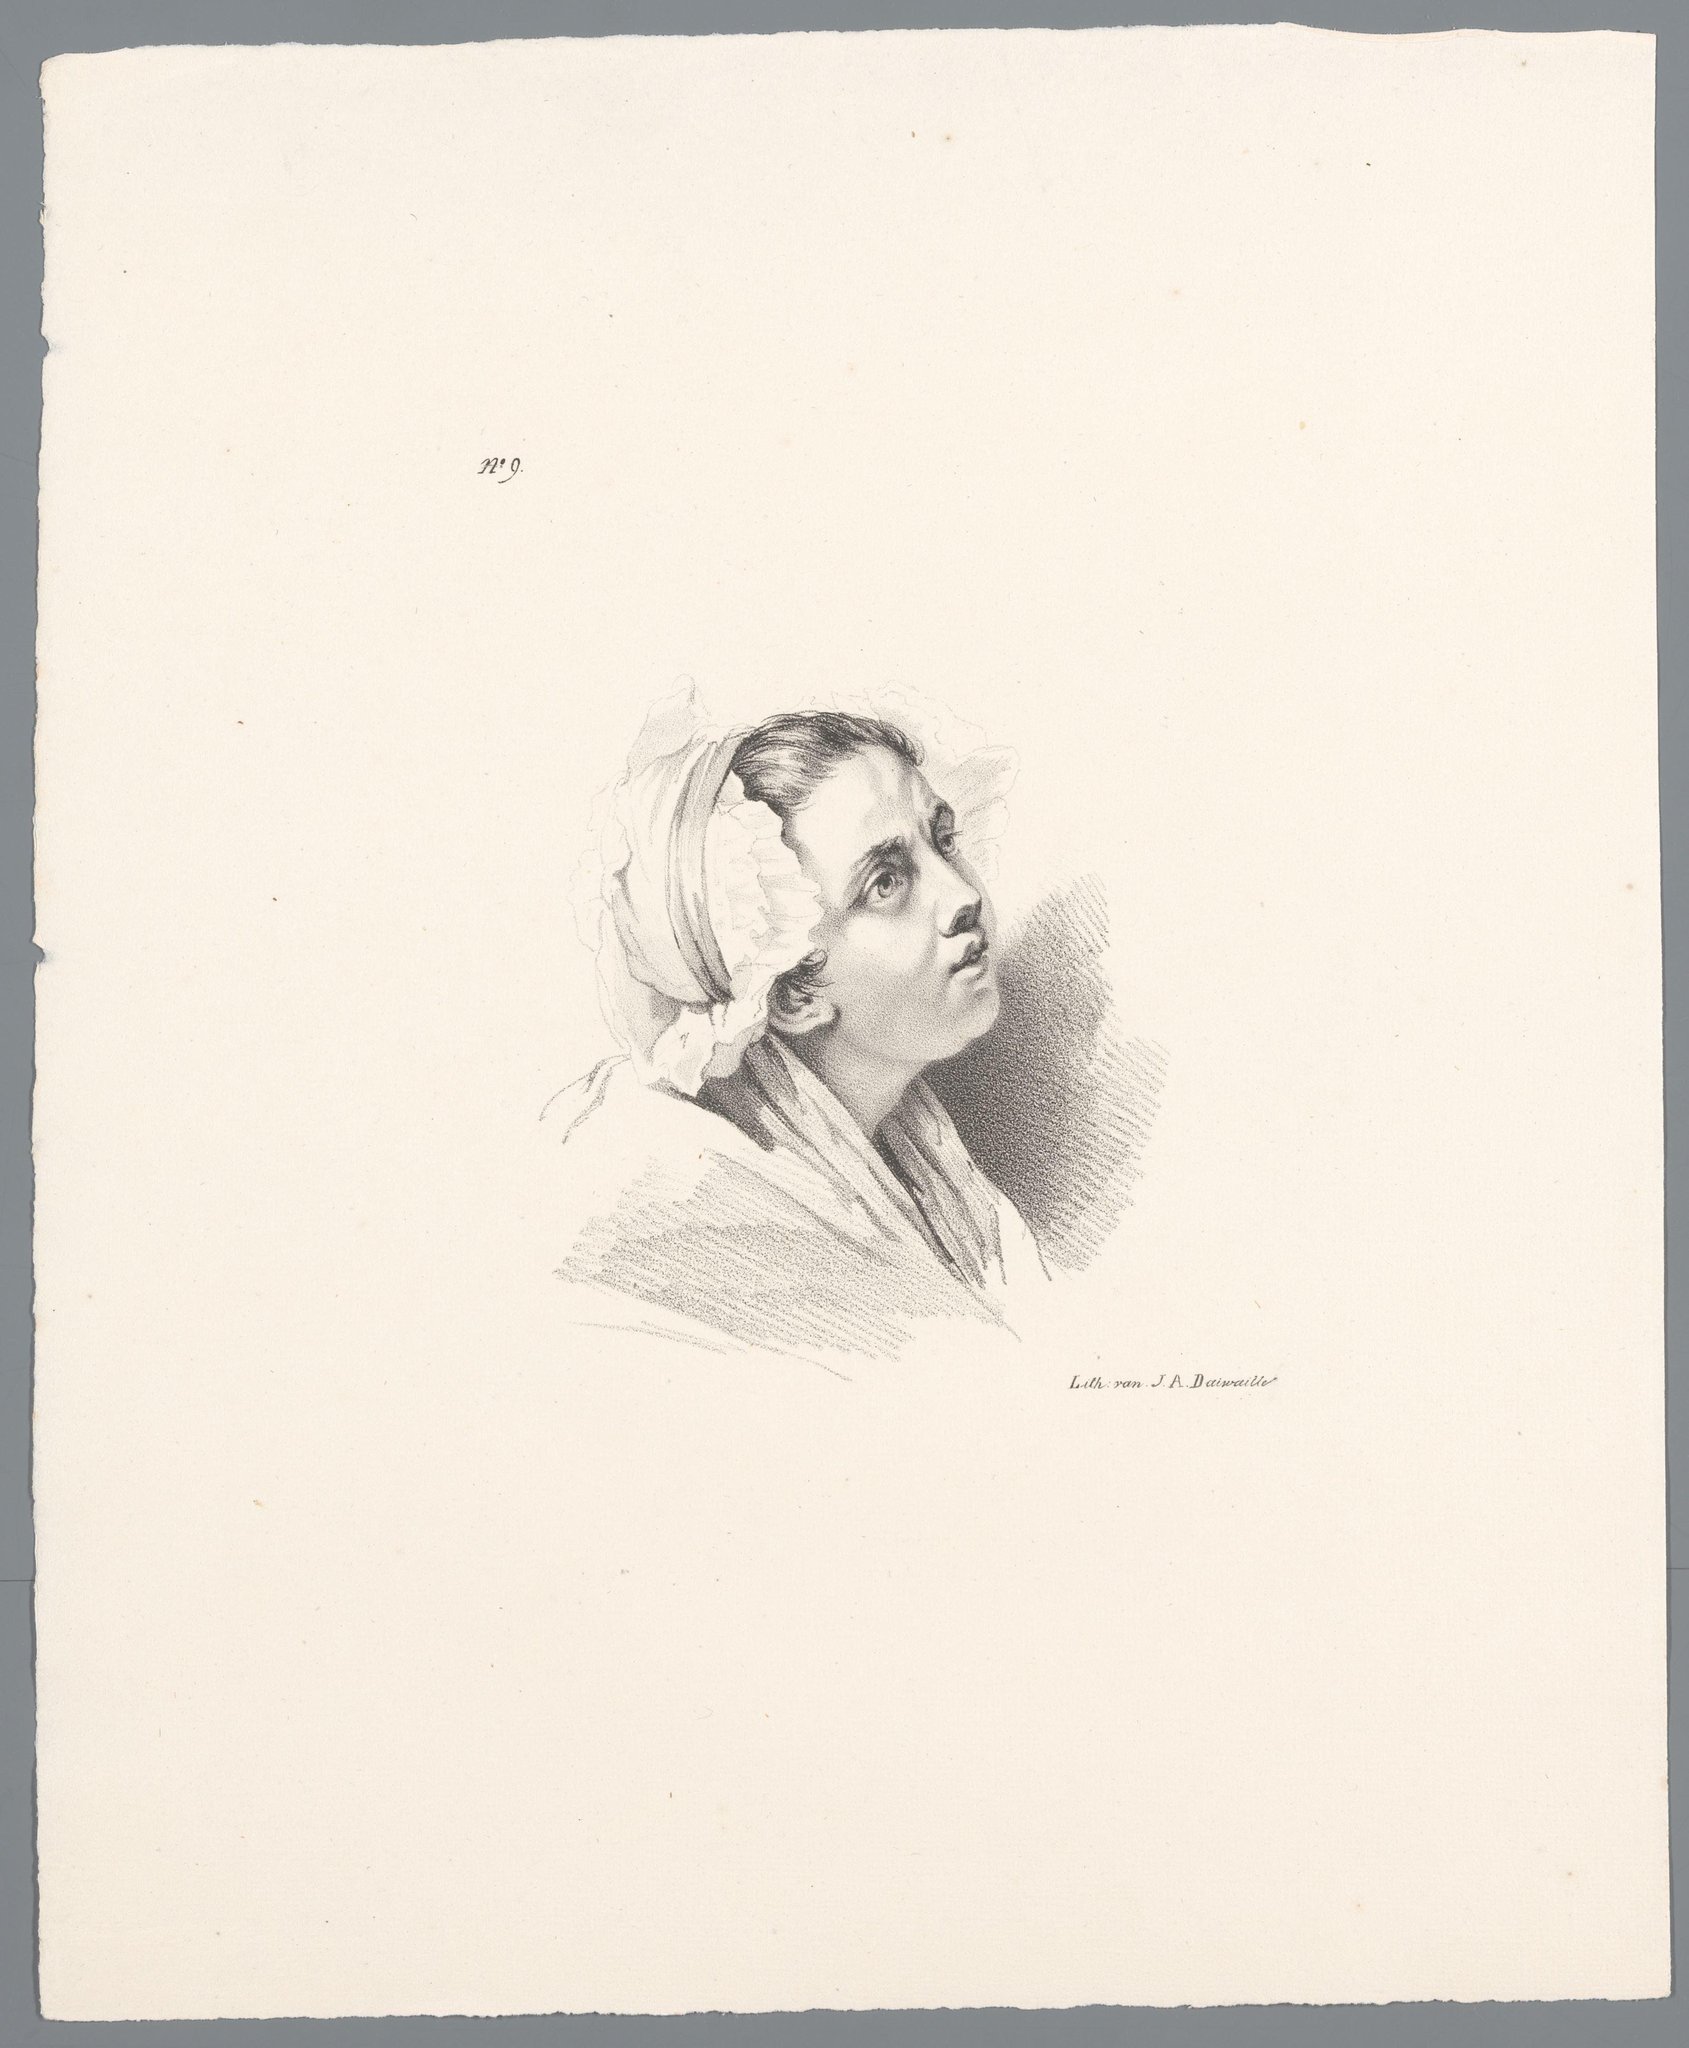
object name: print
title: Hartstochten na J.B. Greuze Nummer Twee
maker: jean augustin daiwaille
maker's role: draughtsman, print maker, printer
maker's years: 1786-1850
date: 1820-1830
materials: paper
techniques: lithograph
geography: amsterdam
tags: adolescent, young woman, maiden, frowned eyebrows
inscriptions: collector's mark: Lugt 2228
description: 'Hartstochten na J.B. Greuze' bestaat uit twee of drie genummerde reeksen. (Sommige nummers komen drie keer voor op drie verschillende afbeeldingen.) Binnen deze omslag bevinden zich achttien verschillende afbeeldingen. Mogelijk heeft dit te maken met de twee momenten waarop Daiwaille de reeks uitgaf, ten tijden van zijn directeurschap aan de Rijksakademie in Amsterdam en daarna als zelfstandige. De omslag behoort waarschijnlijk bij een van deze twee series. Zie Marres-Schretlen in het Bulletin van het Rijksmuseum.